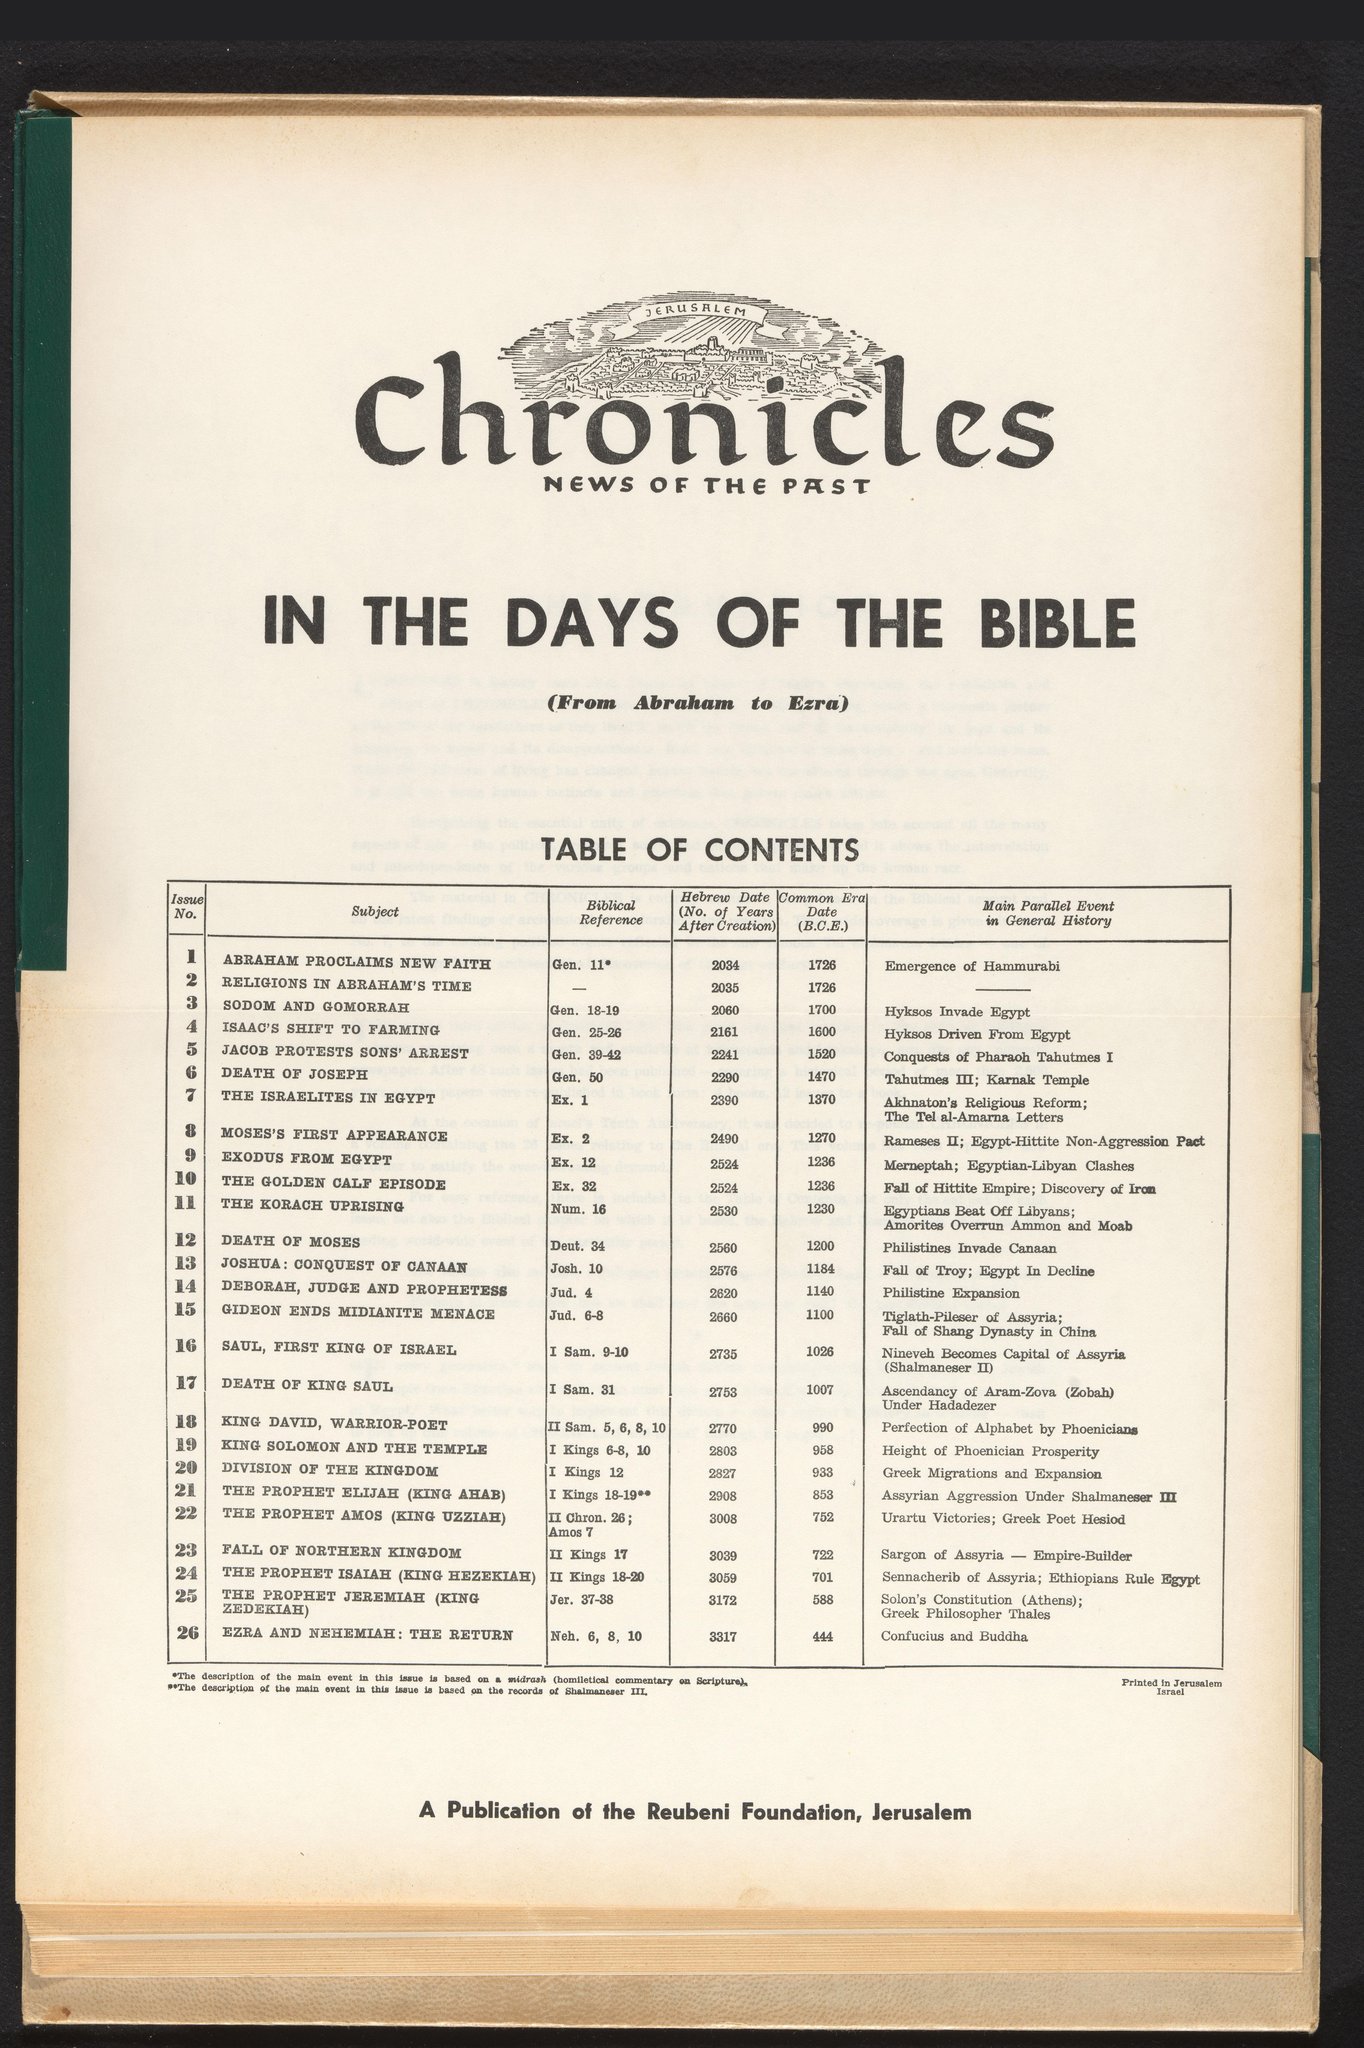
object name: book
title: Chronicles // News of the past // Volume one // In the days of the bible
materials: paper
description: Dit object is onderdeel van de nalatenschap van Isabel Elon-Wachenheimer (1928-2010). Tot haar overlijden behoorde het samen met de andere objecten uit de nalatenschap tot haar privédomein van Isabel Wachenheimer. In die particuliere context zijn deze objecten tezamen en individueel aandenkens - aan de jeugd, ouders en familie van Isabel Wachenheimer vóór en tijdens de Shoah en aan haar leven na de Tweede Wereldoorlog. Isabel Wachenheimer, die van juni 1943 tot mei 1945 gevangen zat in Kamp Westerbork, Theresienstadt, Auschwitz, Lenzing a/d Oberdonau (een buitenkamp van Mauthausen), overleefde de Shoah. Haar ouders – Eugène Wachenheimer en Else Wachenheimer-Moos - werden op 14 oktober 1944 in Auschwitz-Birkenau vermoord.